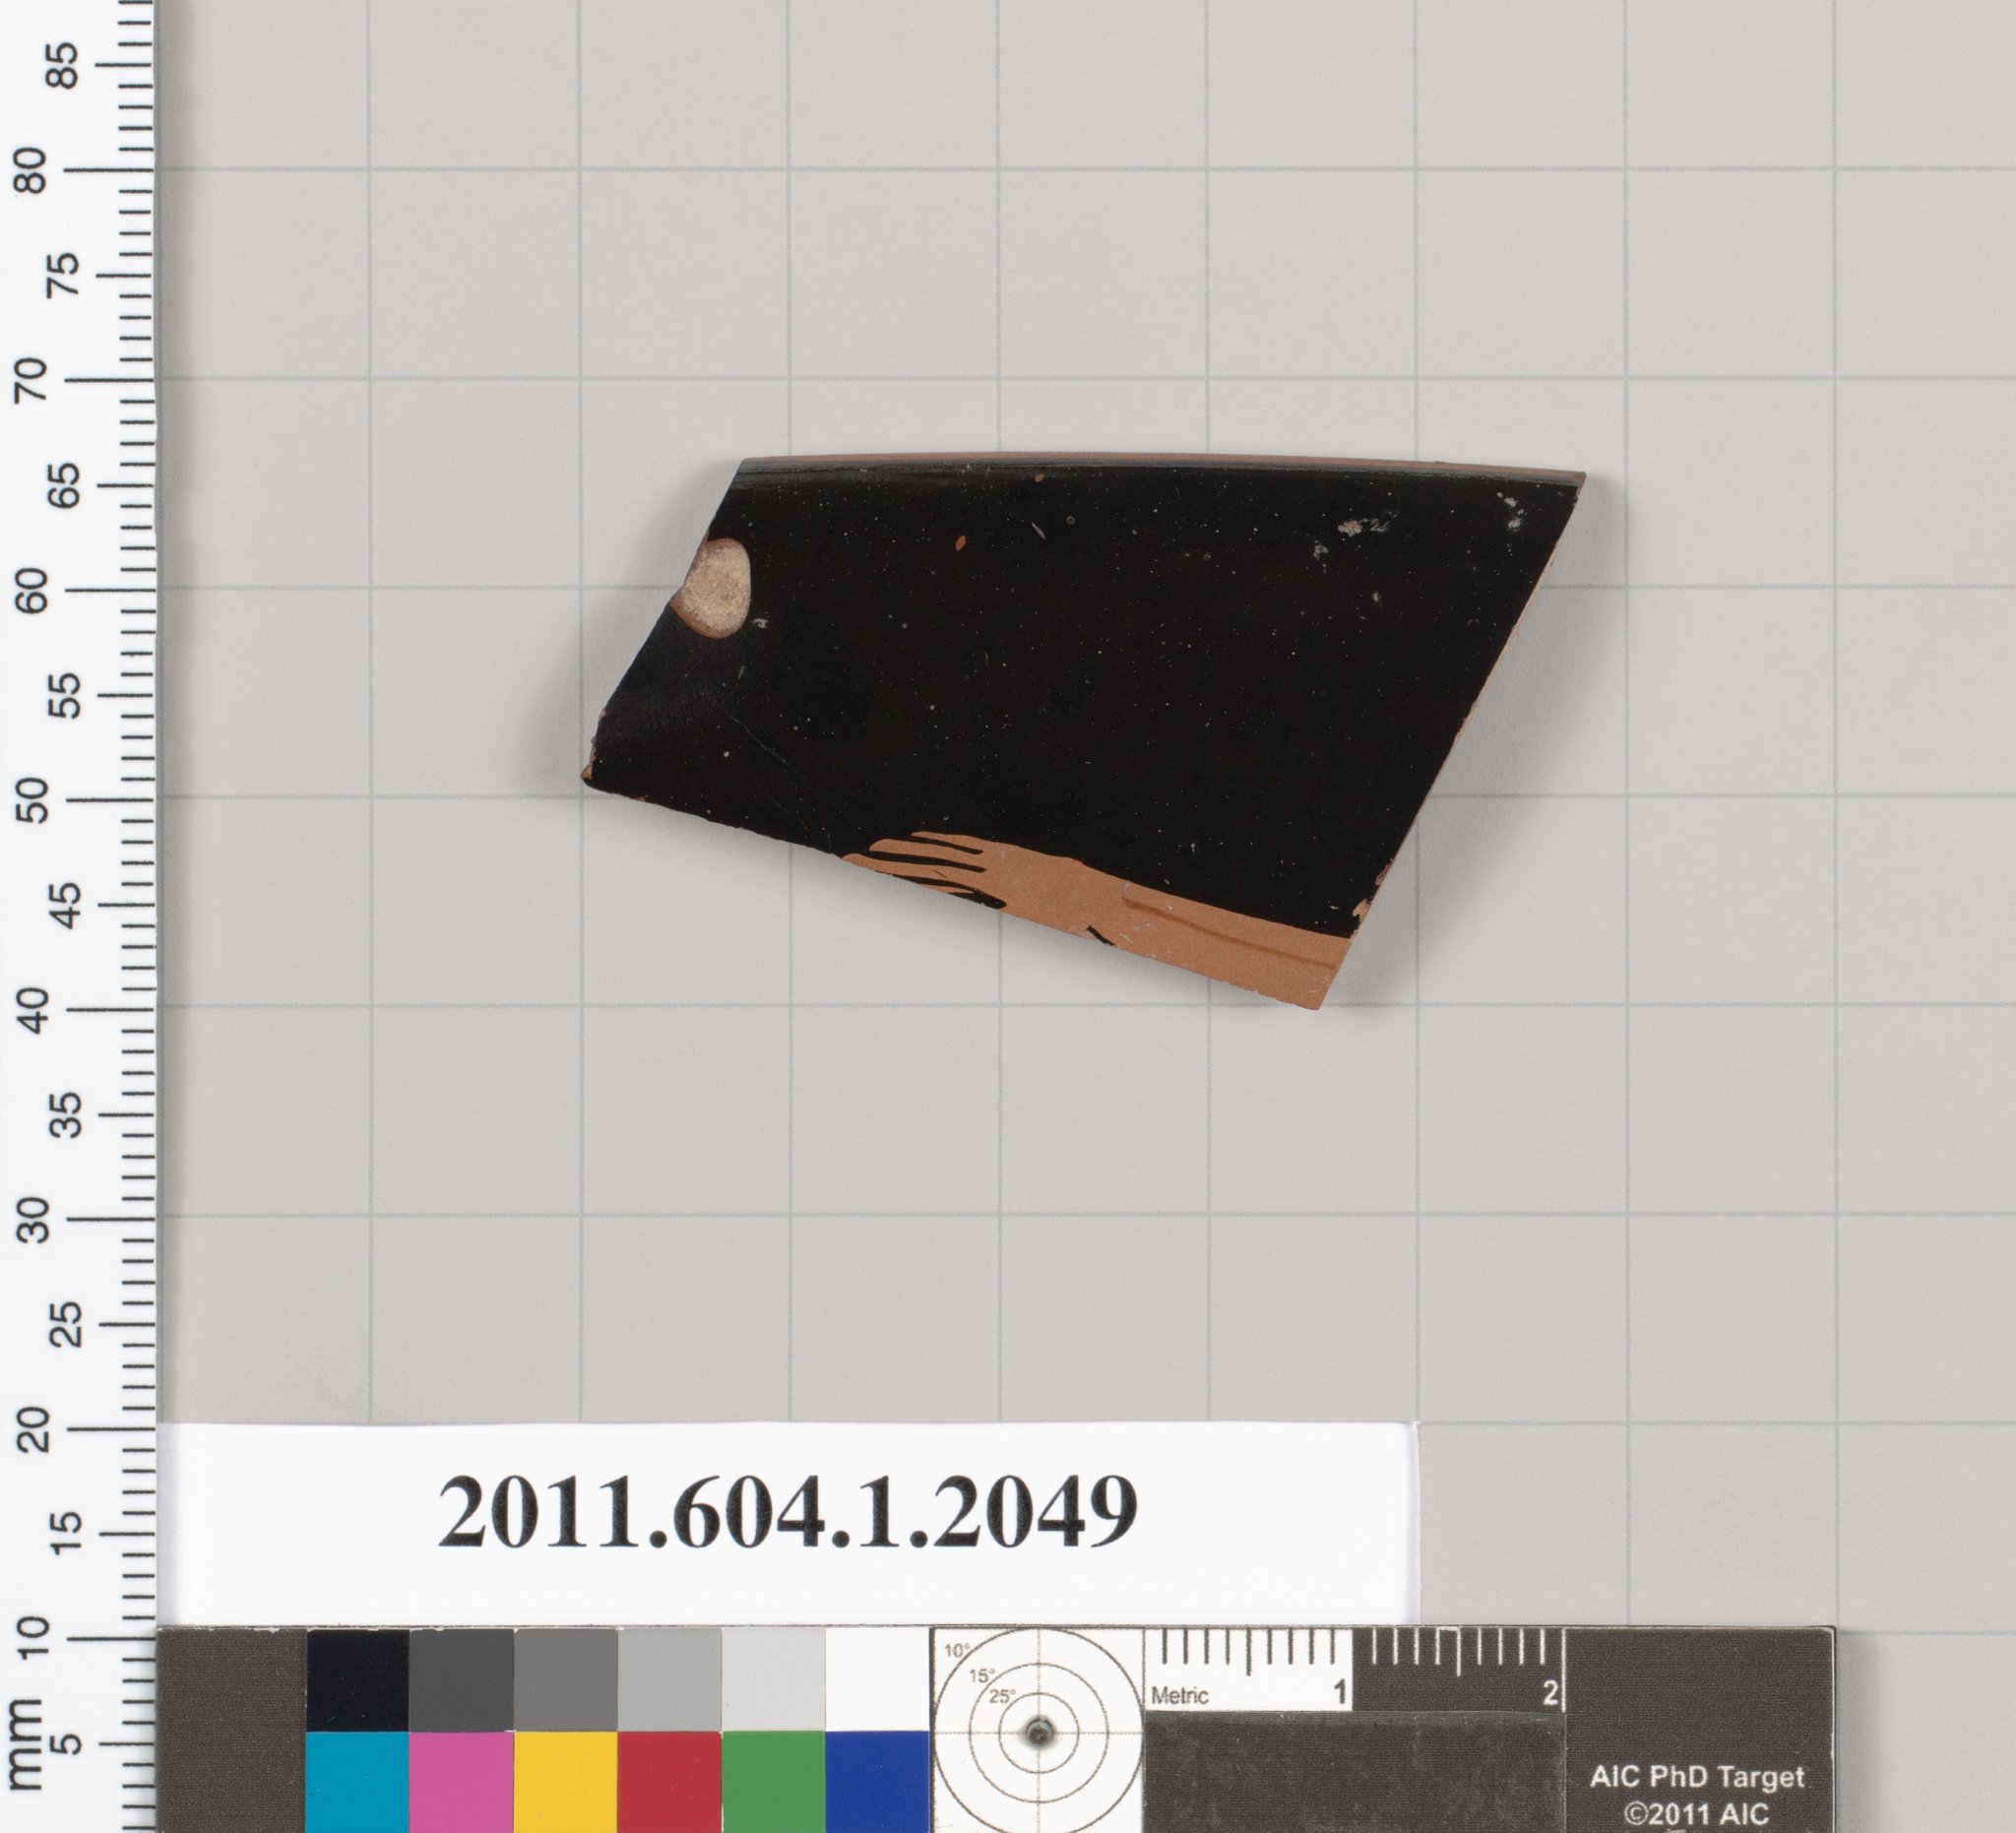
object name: kylix fragment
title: Terracotta rim fragment of a kylix (drinking cup)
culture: greek, attic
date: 475-451 BCE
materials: terracotta